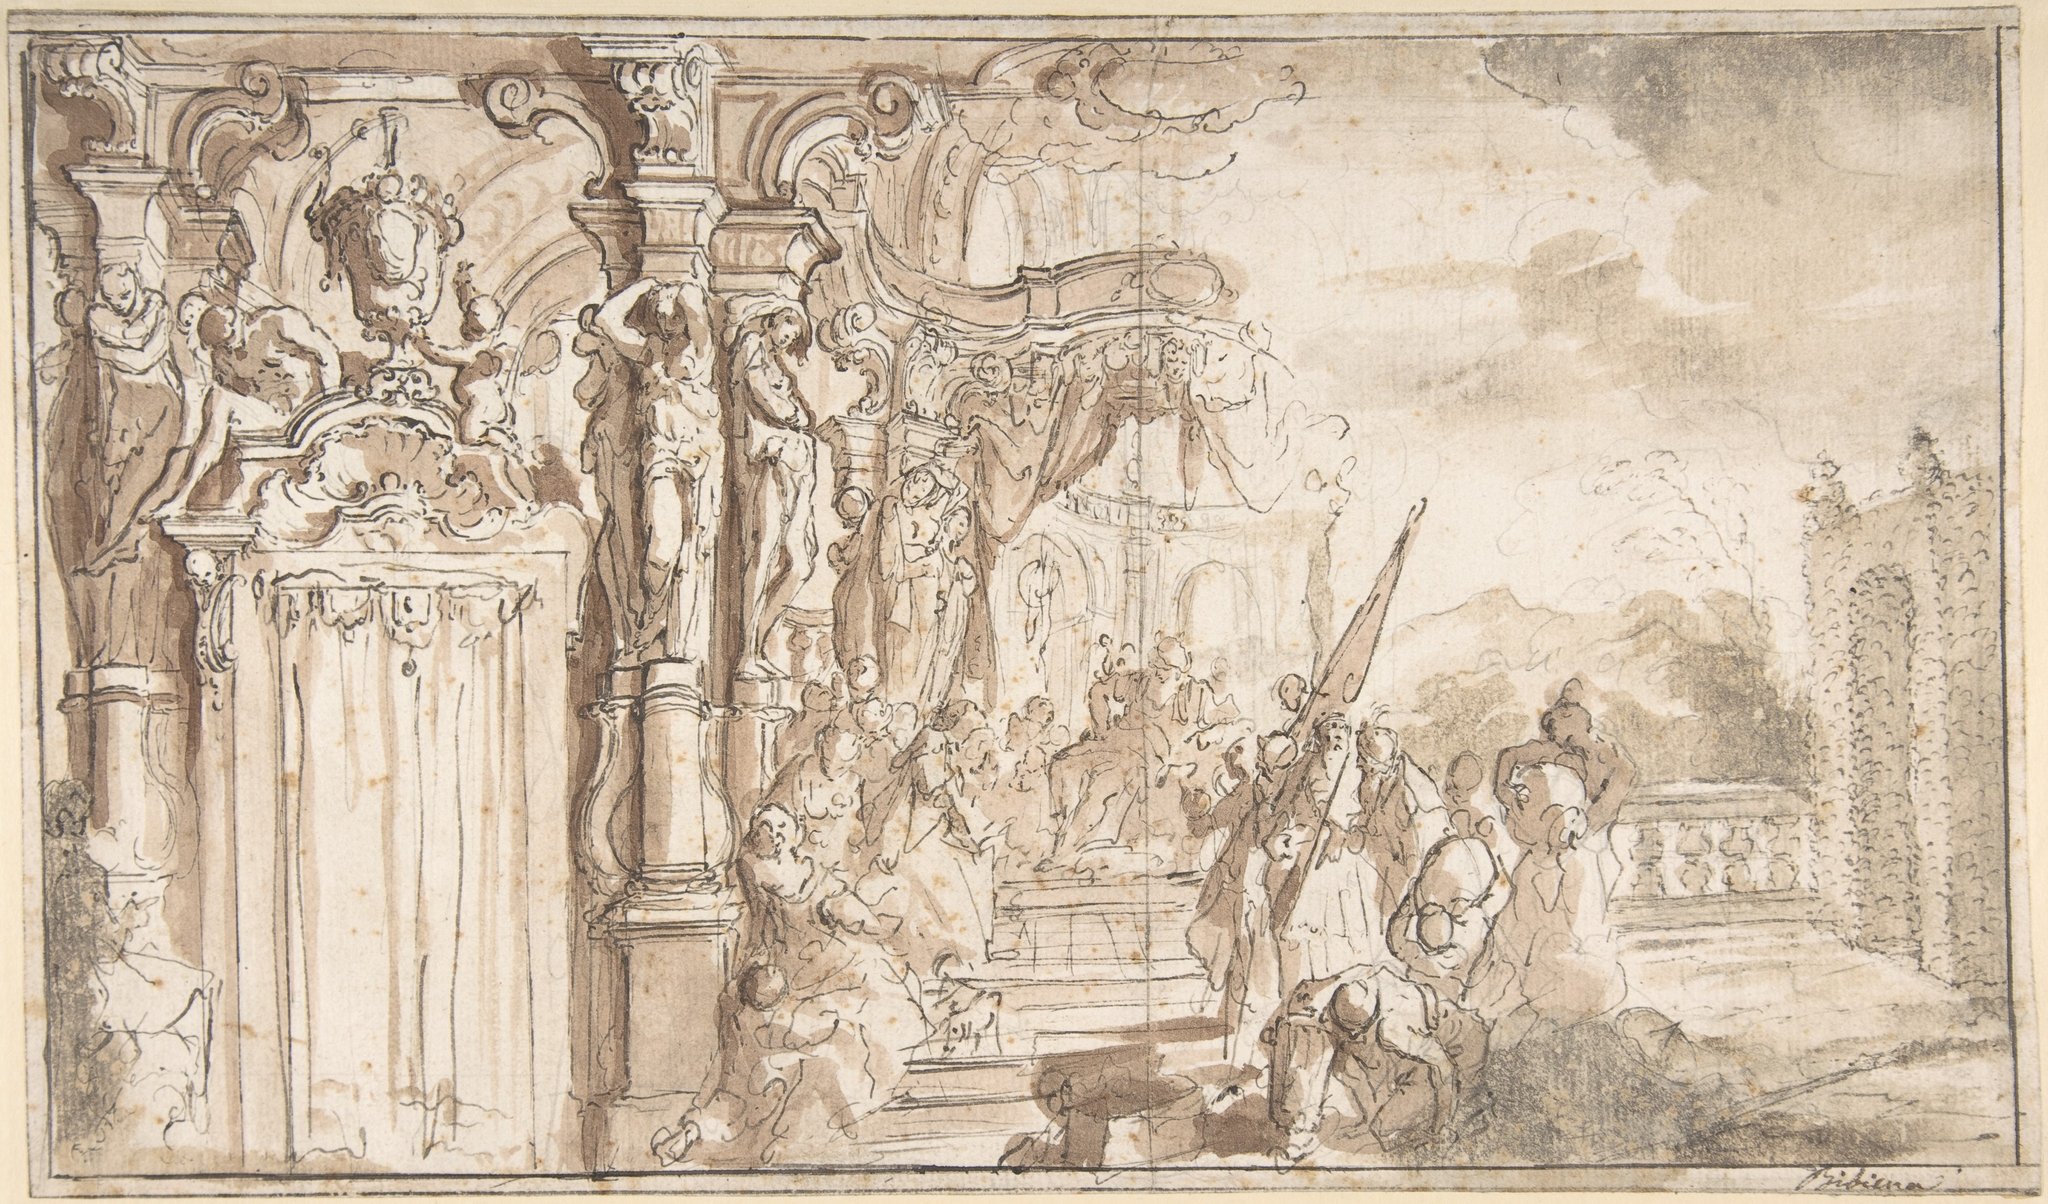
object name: drawing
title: Design for a Stage Set: Solomon Receiving the Queen of Sheba under a Baldacchino, with Fantastical Architecture and a Gardenscape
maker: carlo galli bibiena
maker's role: artist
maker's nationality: italian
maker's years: 1728-1778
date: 1728-1778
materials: graphite, ink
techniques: brush, pen, wash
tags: stage design